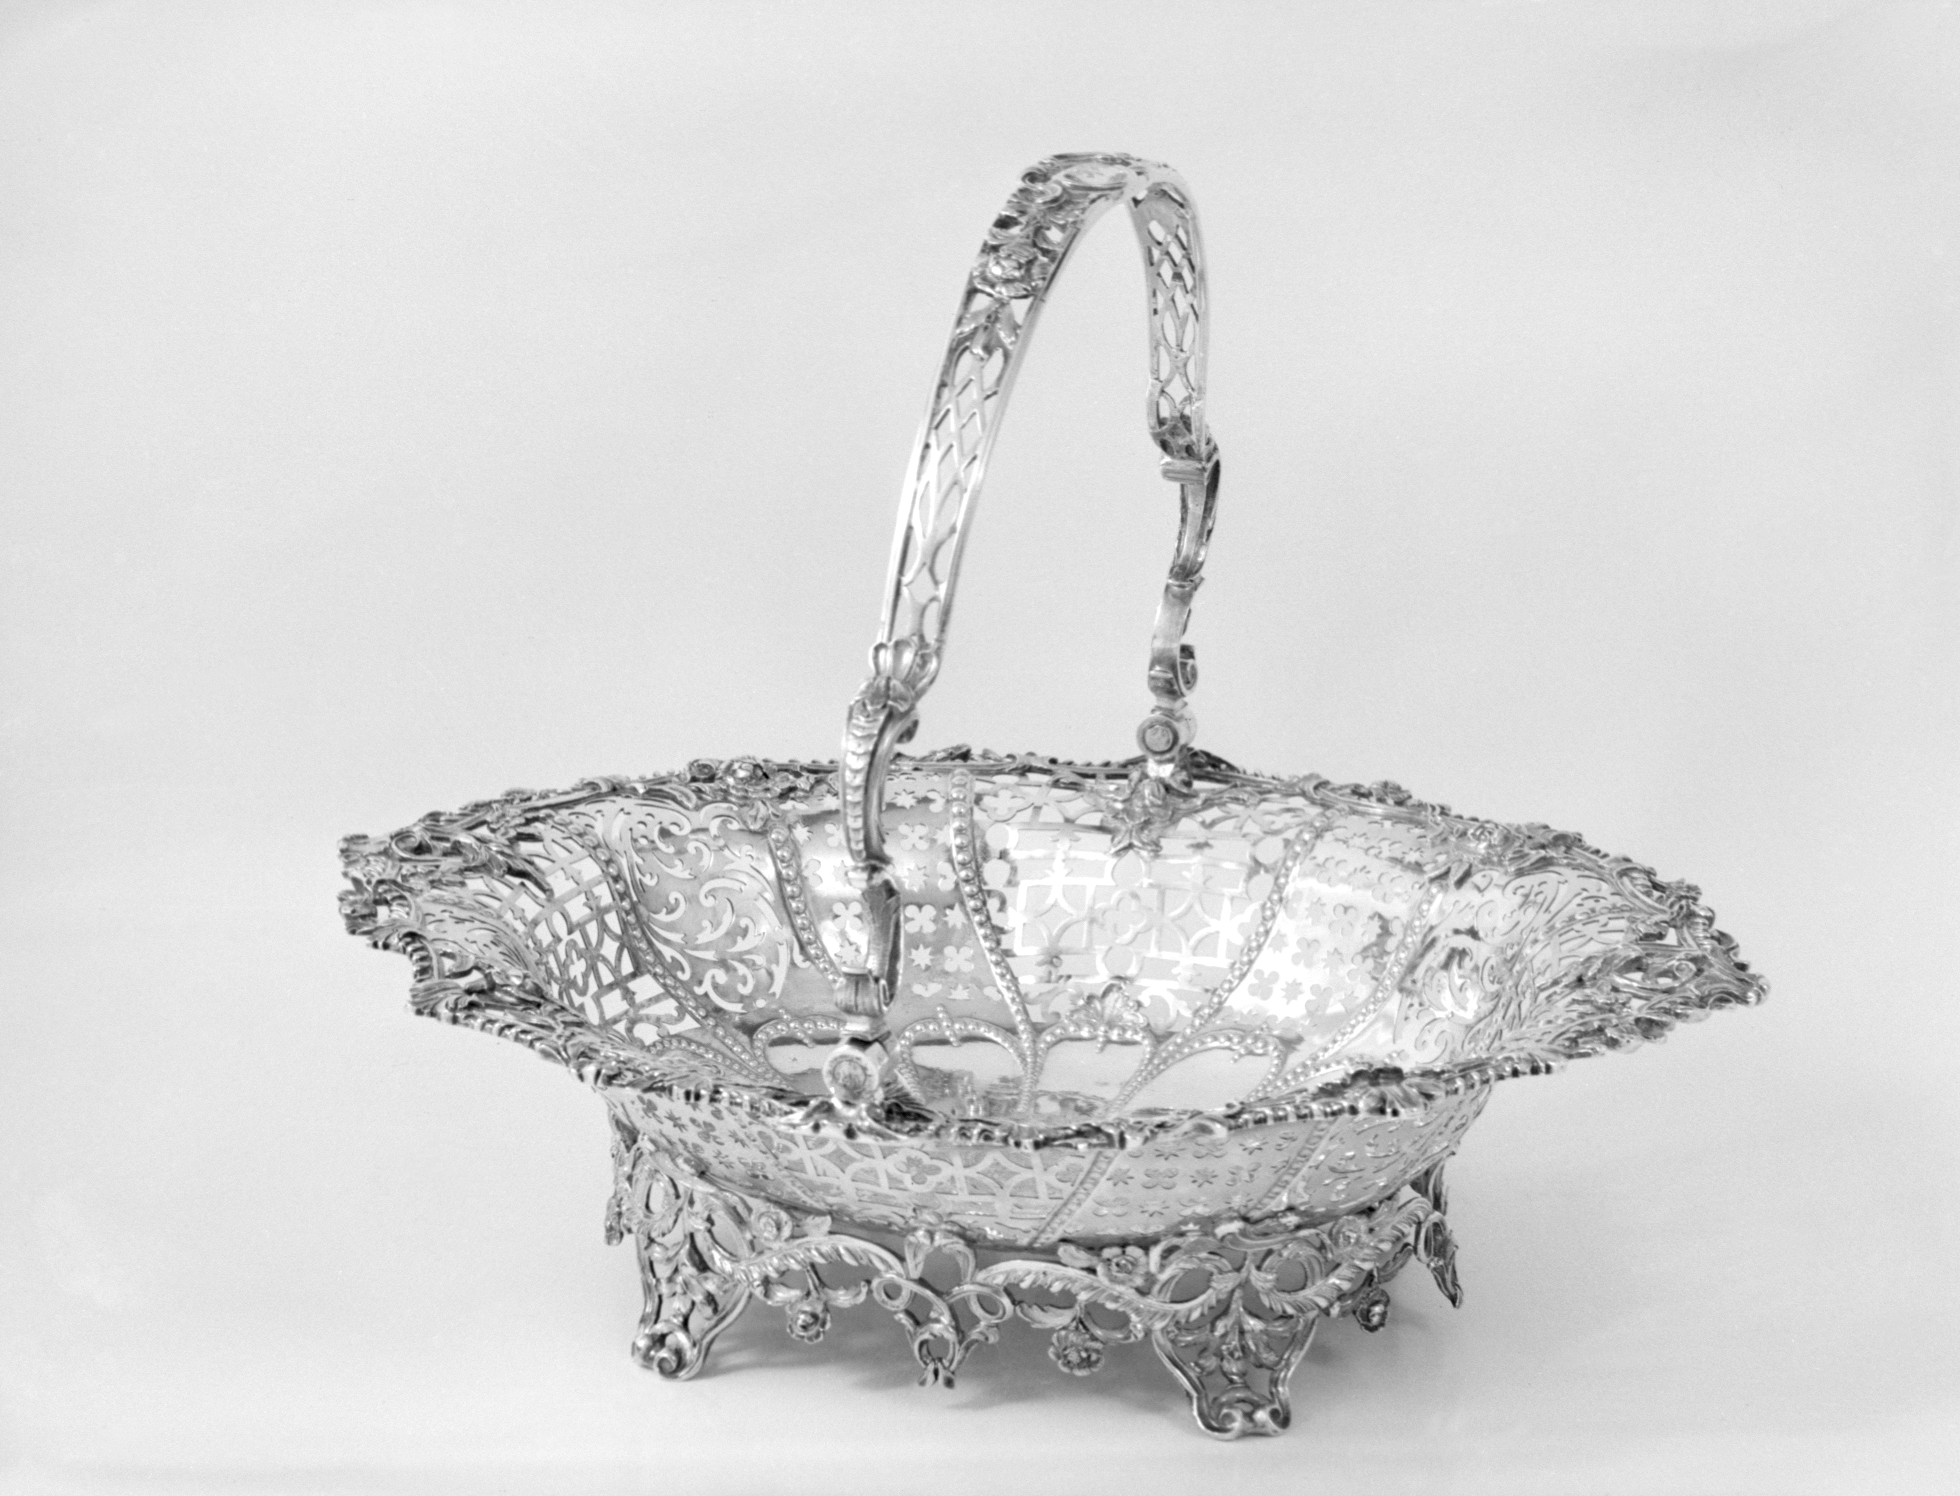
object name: cake basket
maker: john langford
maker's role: maker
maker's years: 1763-1770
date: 1763-1764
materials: silver